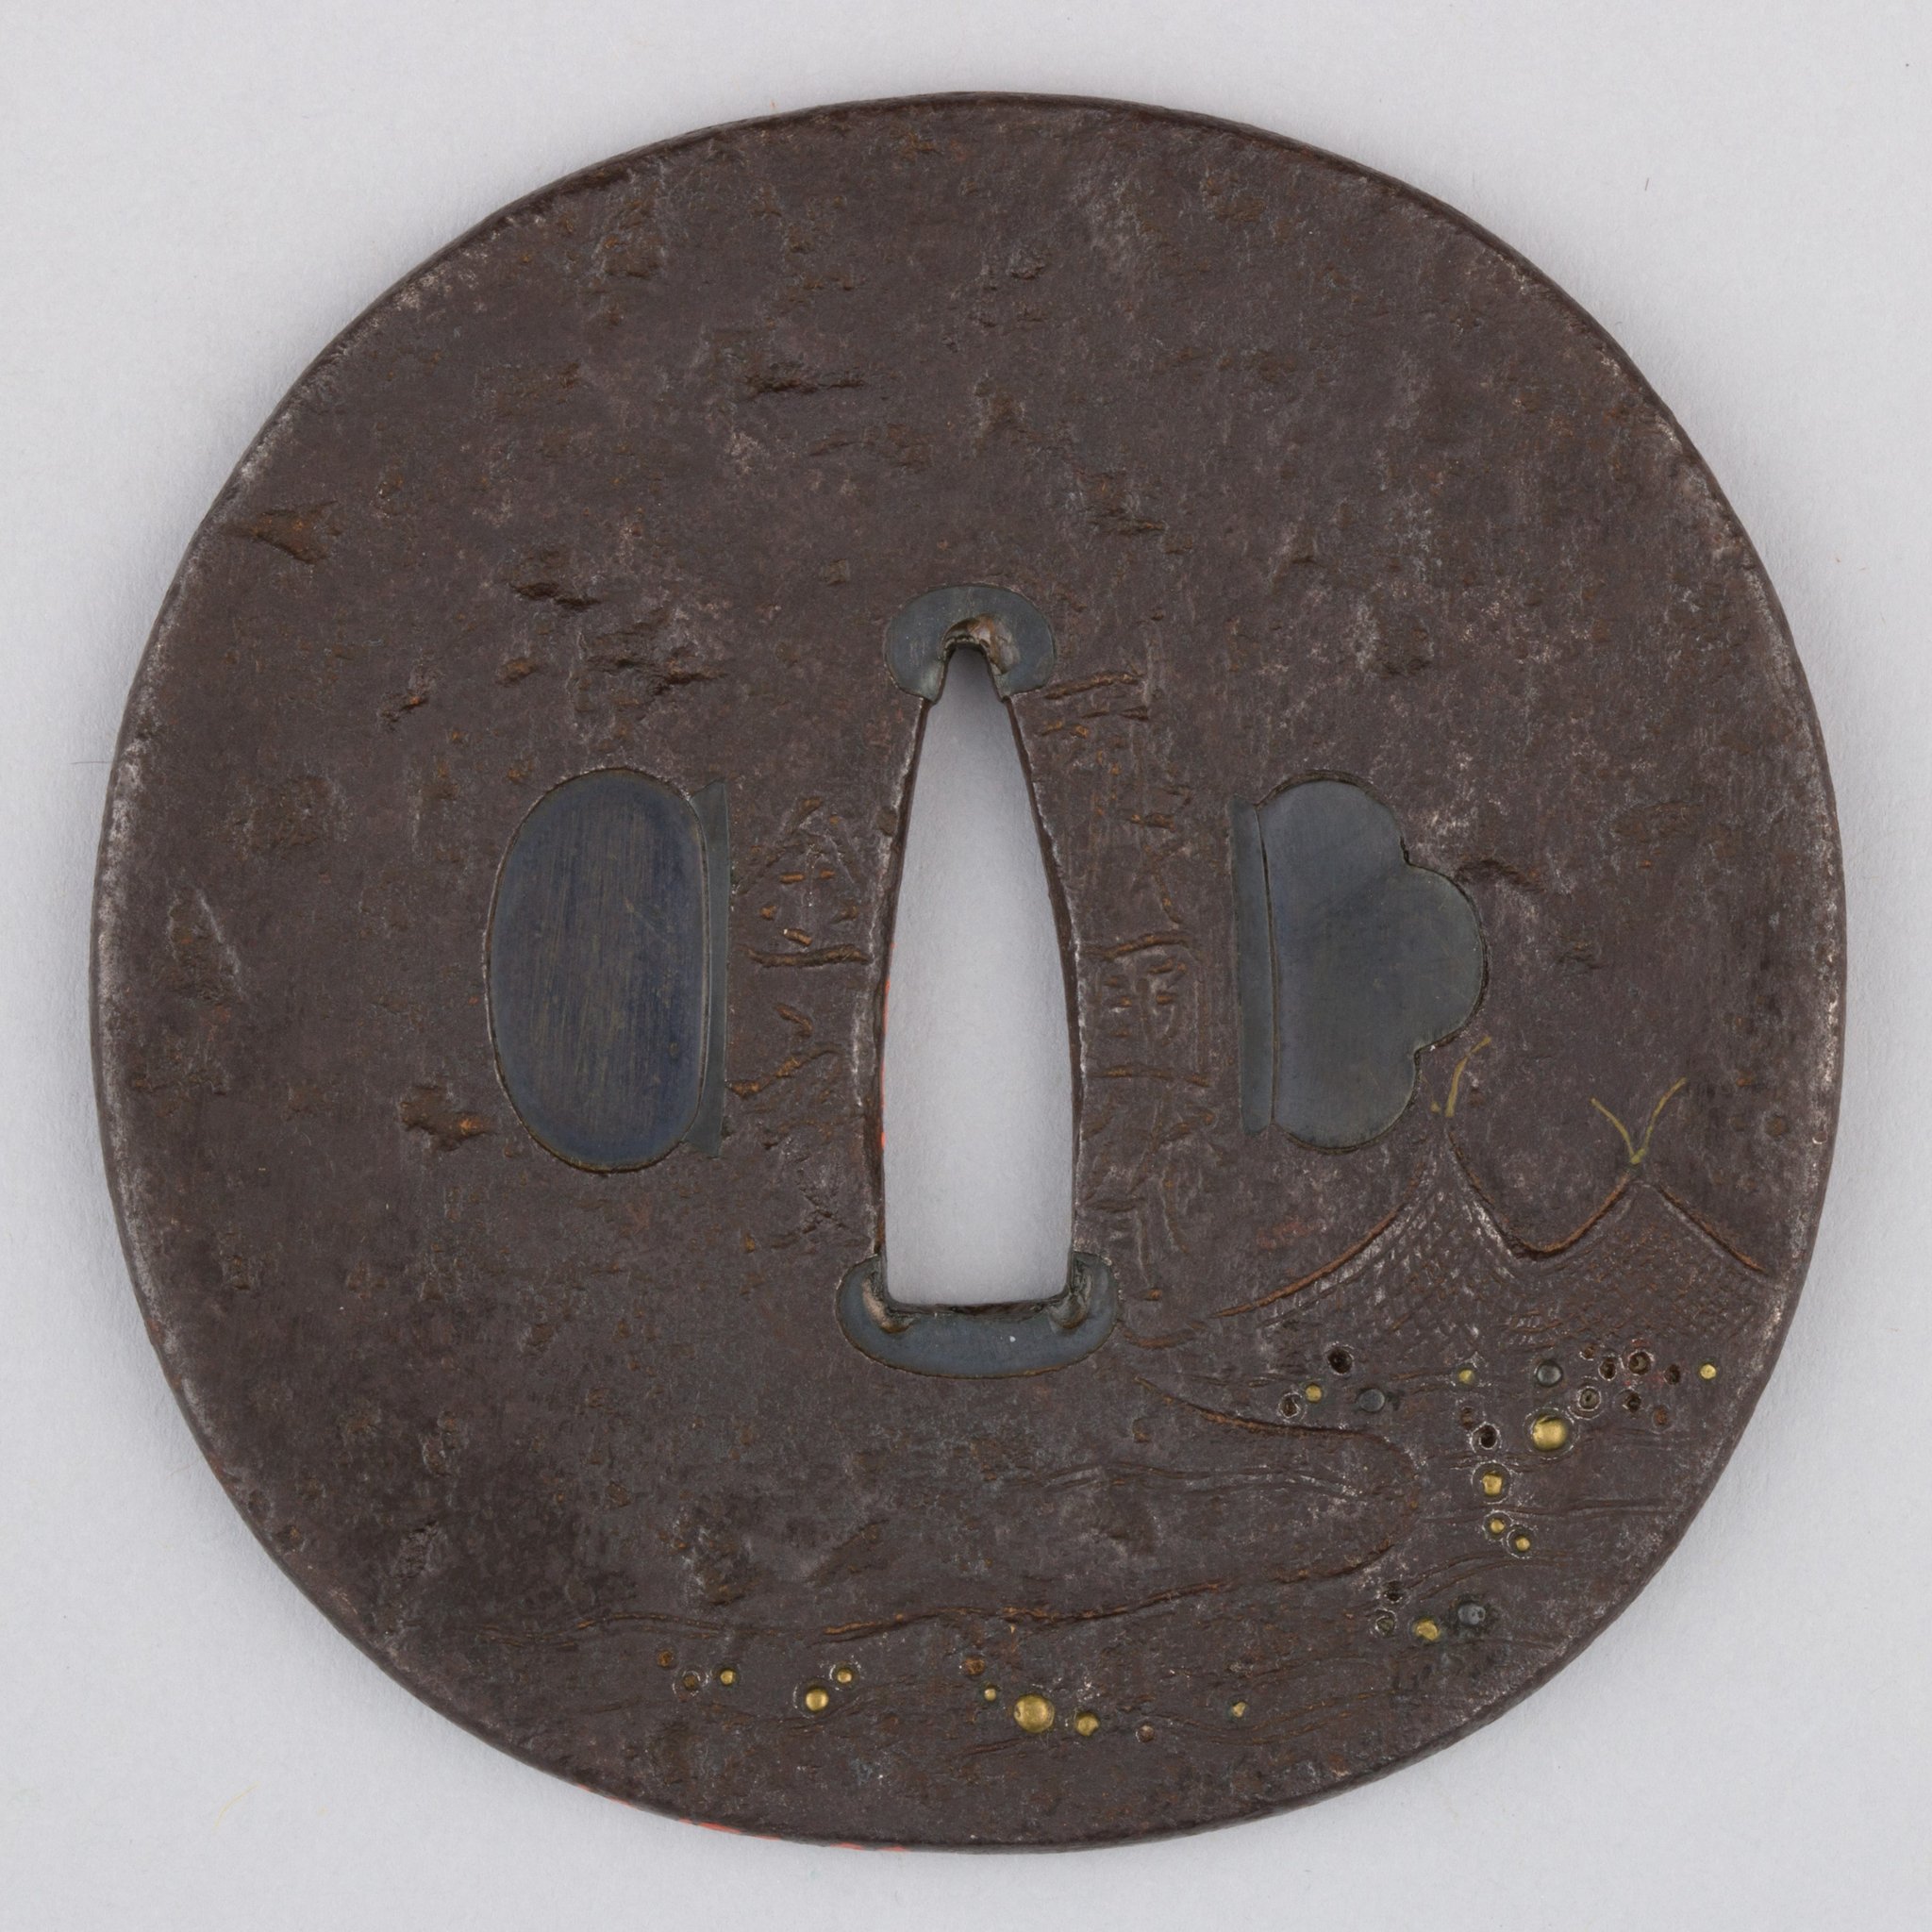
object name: sword guard tsuba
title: Sword Guard (Tsuba)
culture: japanese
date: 1615-1868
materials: copper, iron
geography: japan